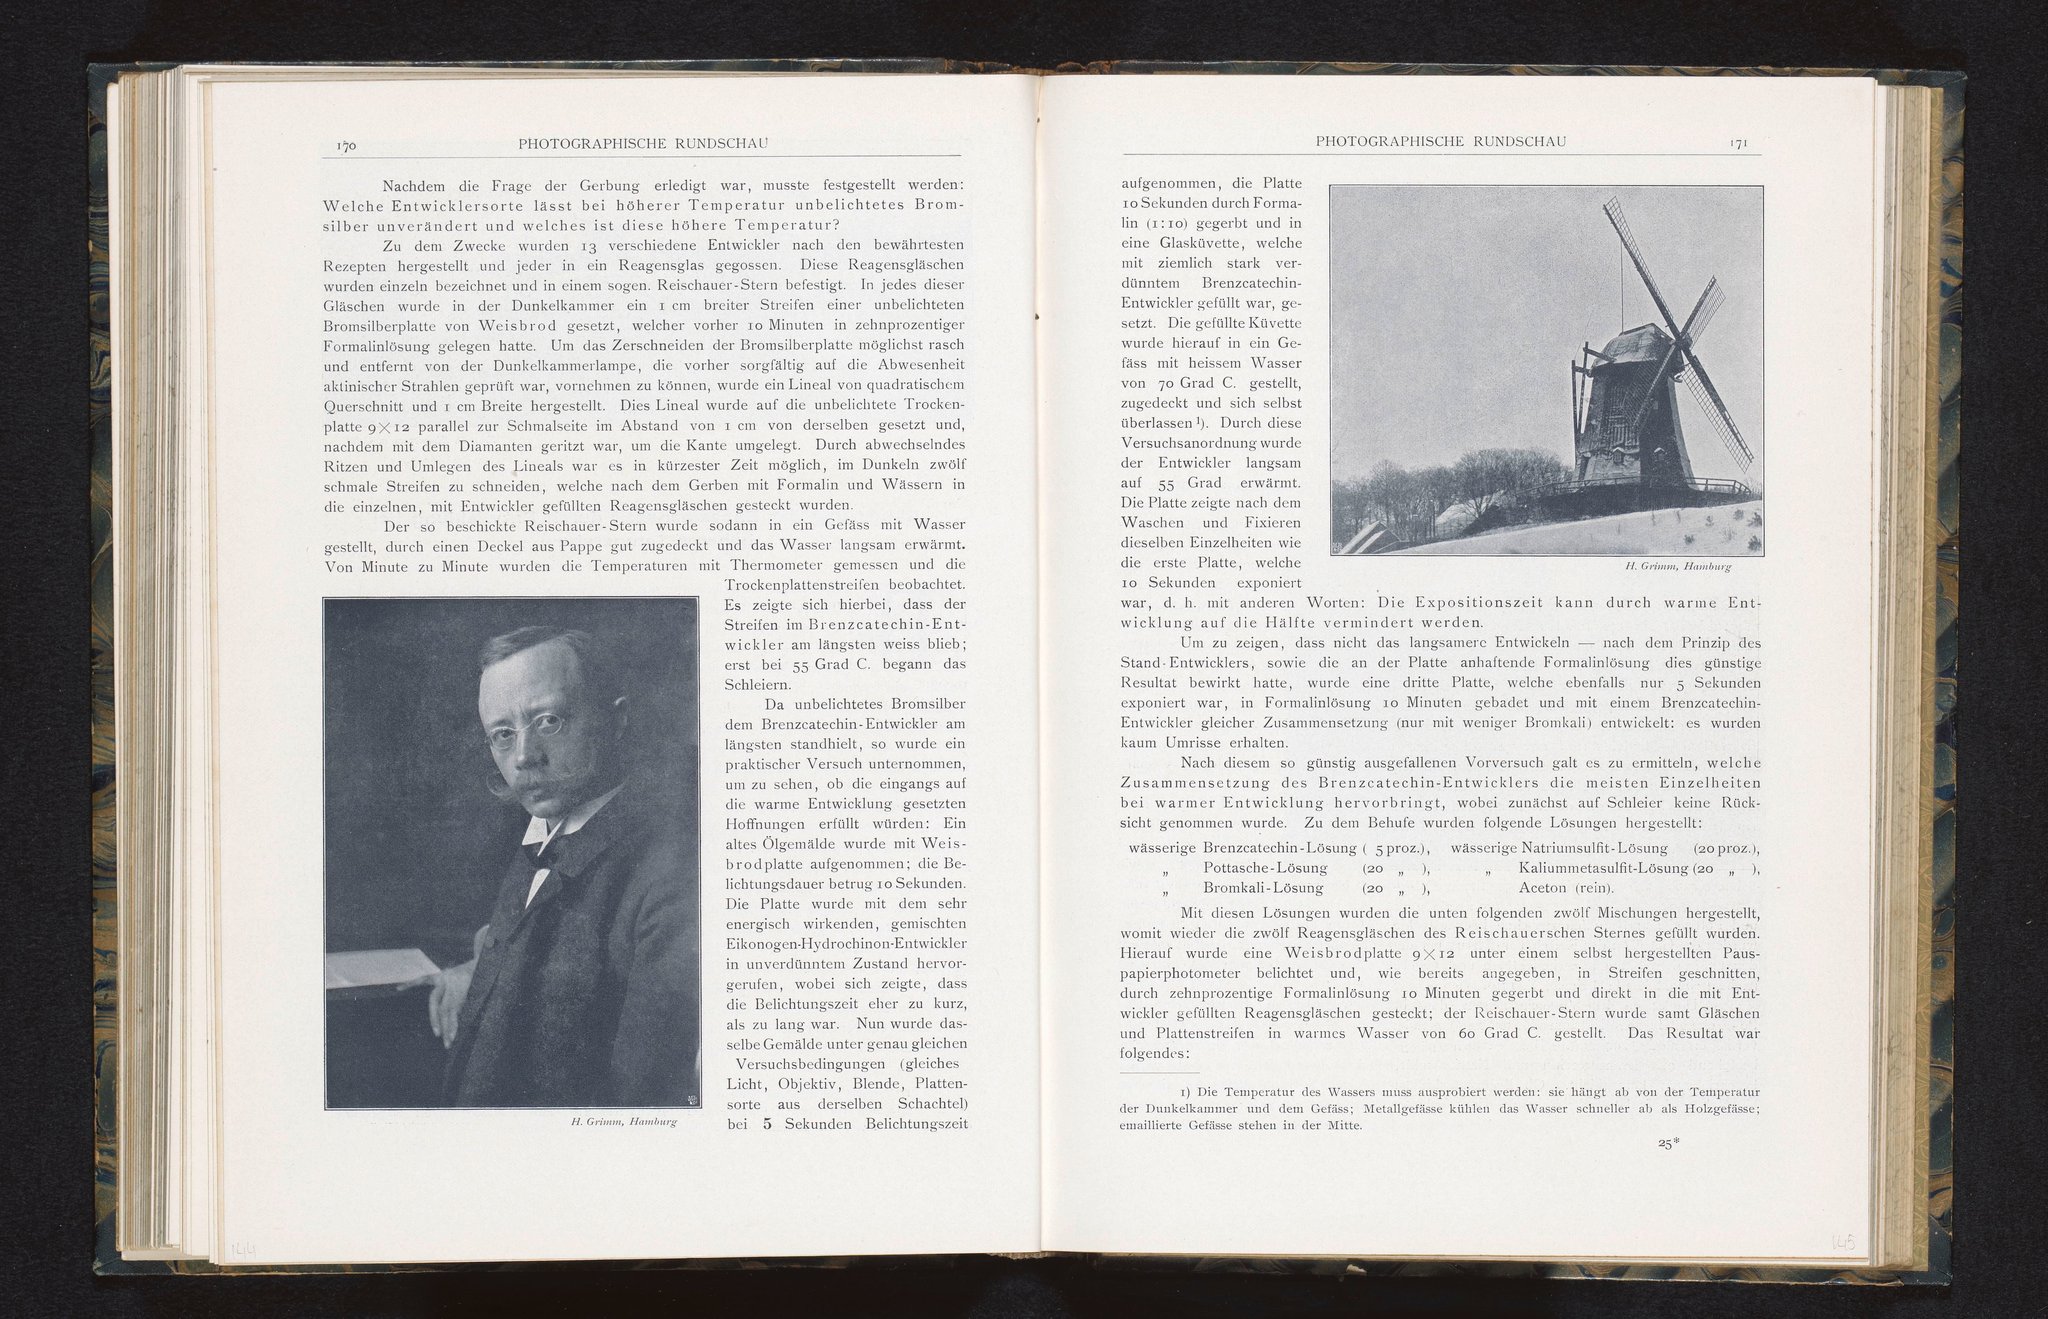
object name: page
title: Gezicht op een molen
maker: h. grimm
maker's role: fotograaf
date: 1895-1900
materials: paper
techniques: autotype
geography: berlin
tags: windmill in landscape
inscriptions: inscription: ‘MR/&Co’